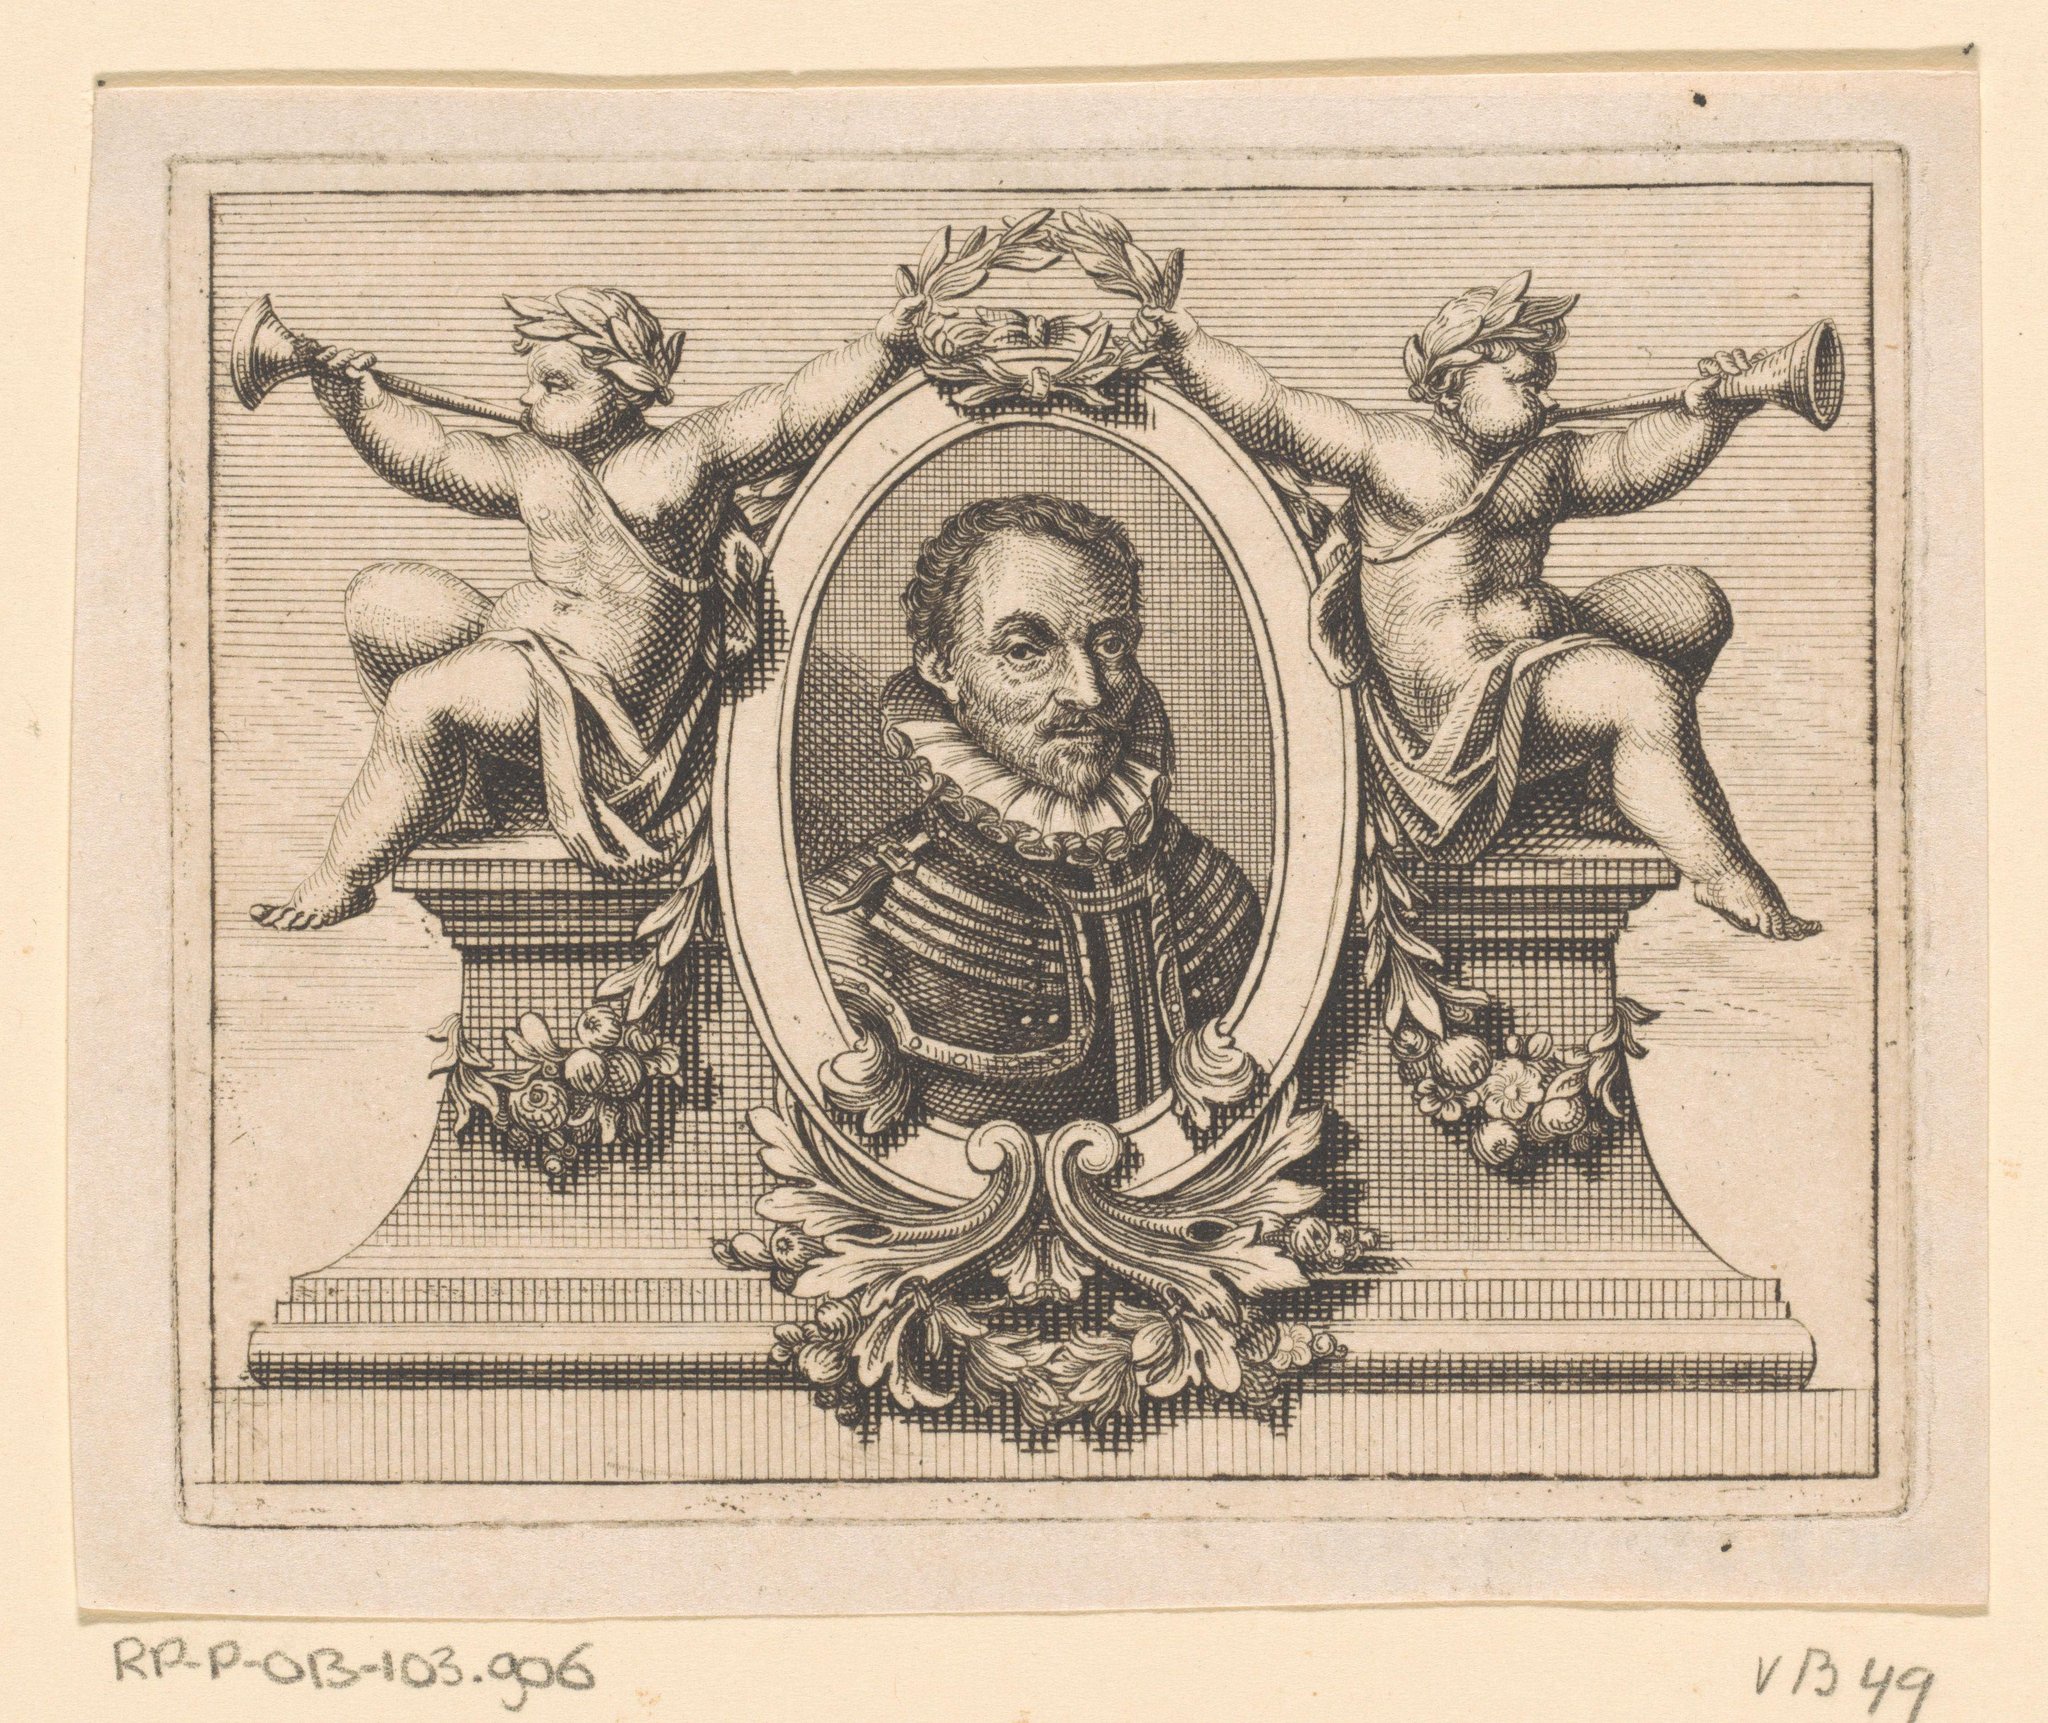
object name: print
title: Portret van Willem I, prins van Oranje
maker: Anonymous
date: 1701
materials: paper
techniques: engraving, etching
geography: low countries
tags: delft, william i (prince of orange)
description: De hier vermelde titel verwijst naar de hoogst verkregen titel van de geportretteerde, niet per se naar de titel die de geportretteerde op deze voorstelling draagt.